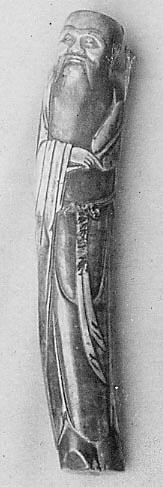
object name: figure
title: Carved Figure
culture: chinese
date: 1401-1500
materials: ivory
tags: men